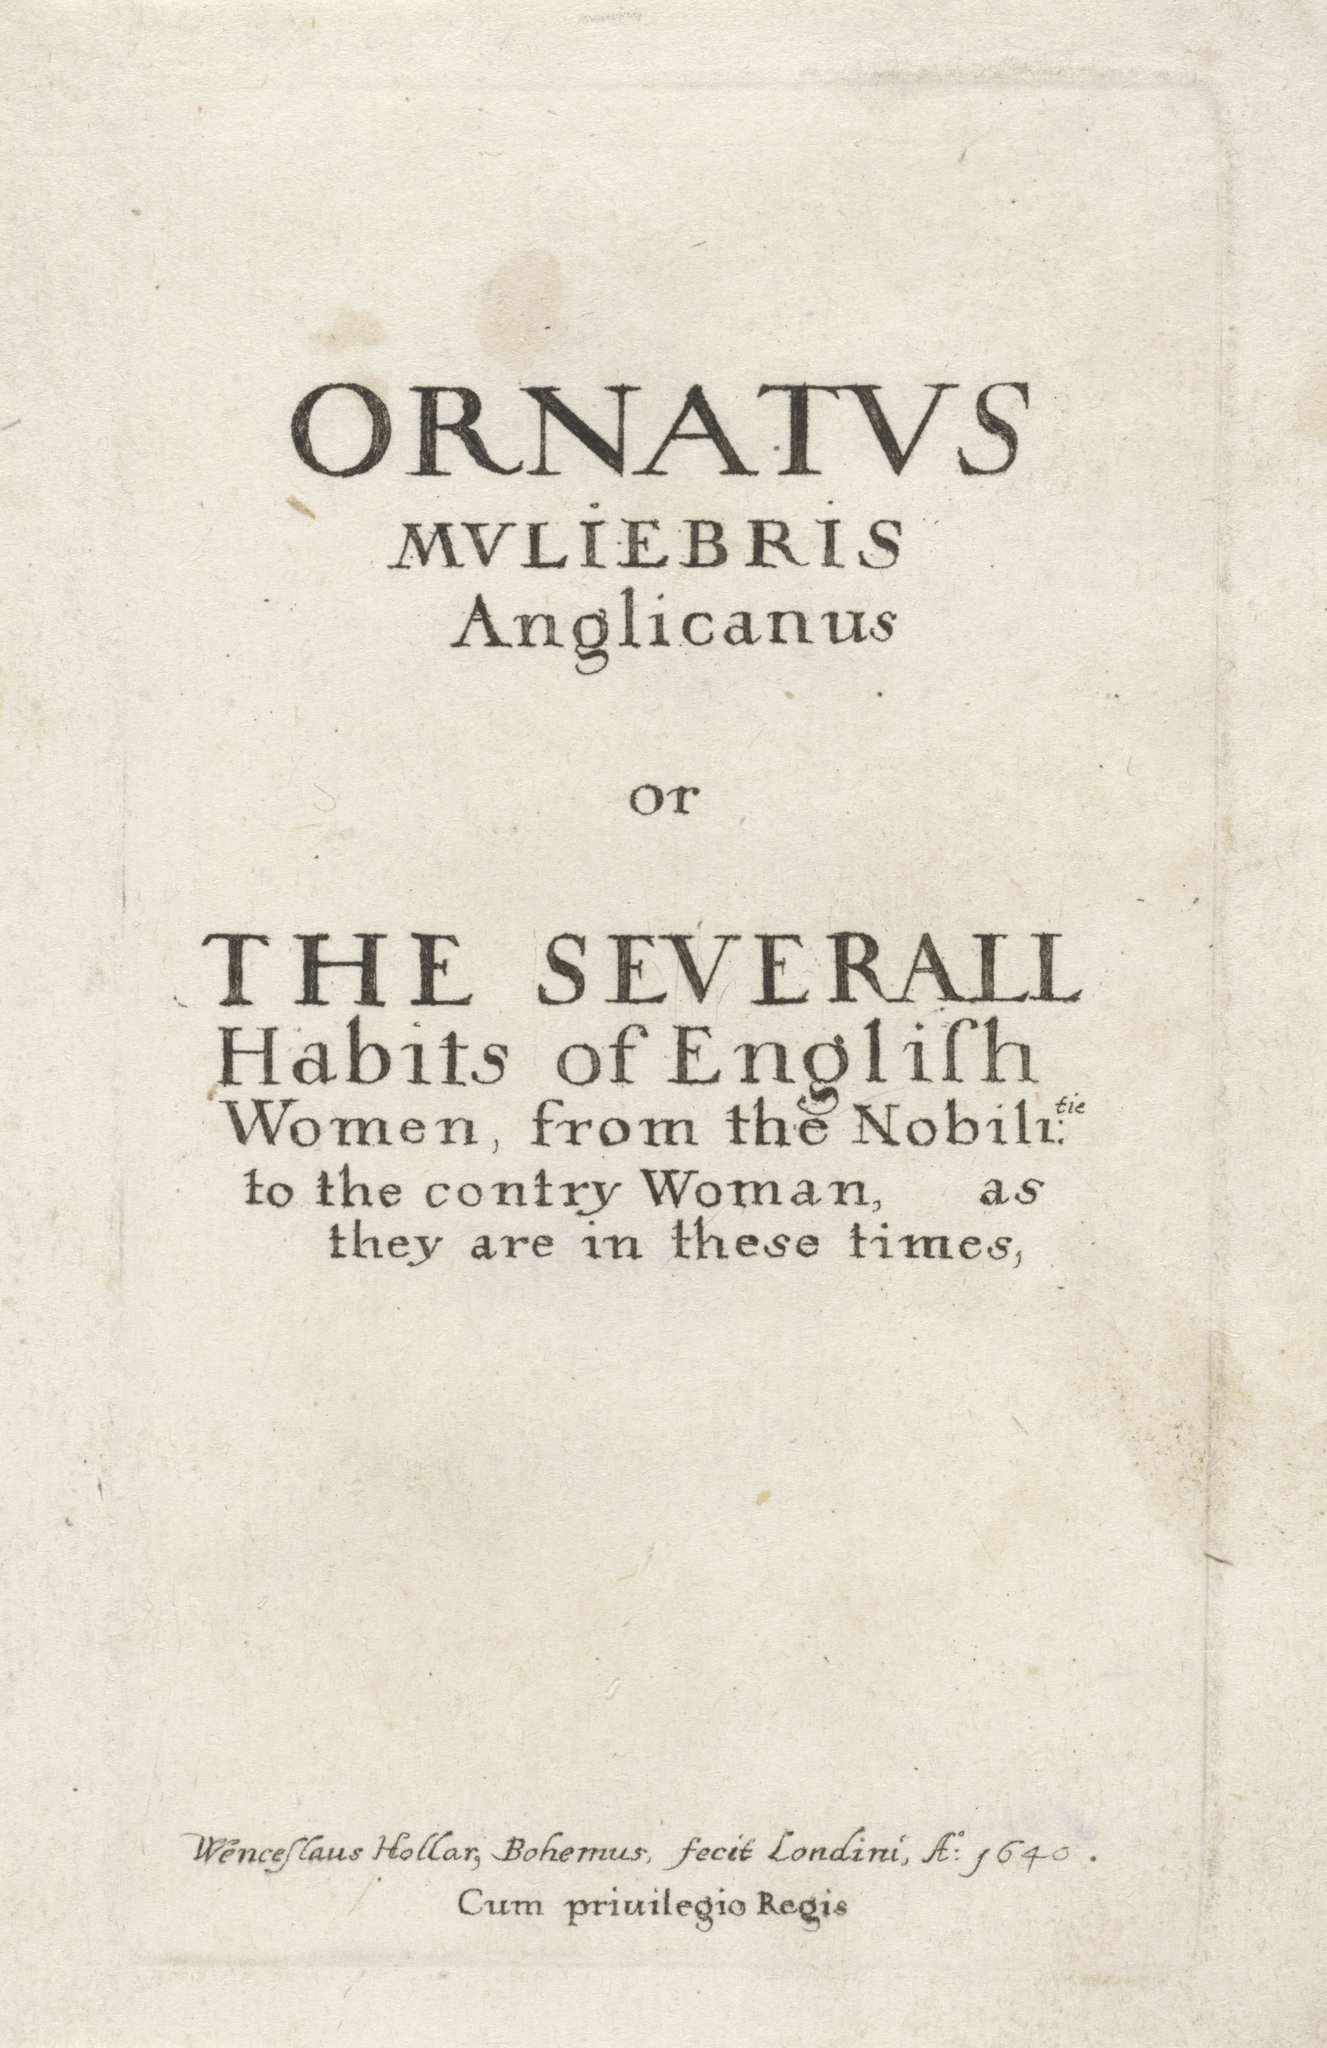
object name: costume print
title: Titelprent voor: Ornatus Muliebris Anglicanus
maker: wenceslaus hollar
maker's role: draughtsman, print maker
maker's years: 1607-1677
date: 1640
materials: paper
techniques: etching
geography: london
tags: title-page, europeans: englishmen (+ costume), clothes, costume (+ women's clothes), england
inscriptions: signature: ‘Wenceslaus Hollar, Bohemus, fecit Londini Ae 1640 / Cum privilegio Regis’, date: ‘1640’, collector's mark: Lugt 654, title: ‘The Severall Habits of English Women from the Nobiltis to the contry Woman, as they are in these times.’, title: ‘Ornatvs Muliebris Anglicanus’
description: Titelprent (ongenummerd) voor 26-delige serie met vrouwen gekleed volgens de Engelse mode van ca. 1640, getiteld "Ornatus Muliebris Anglicanus".